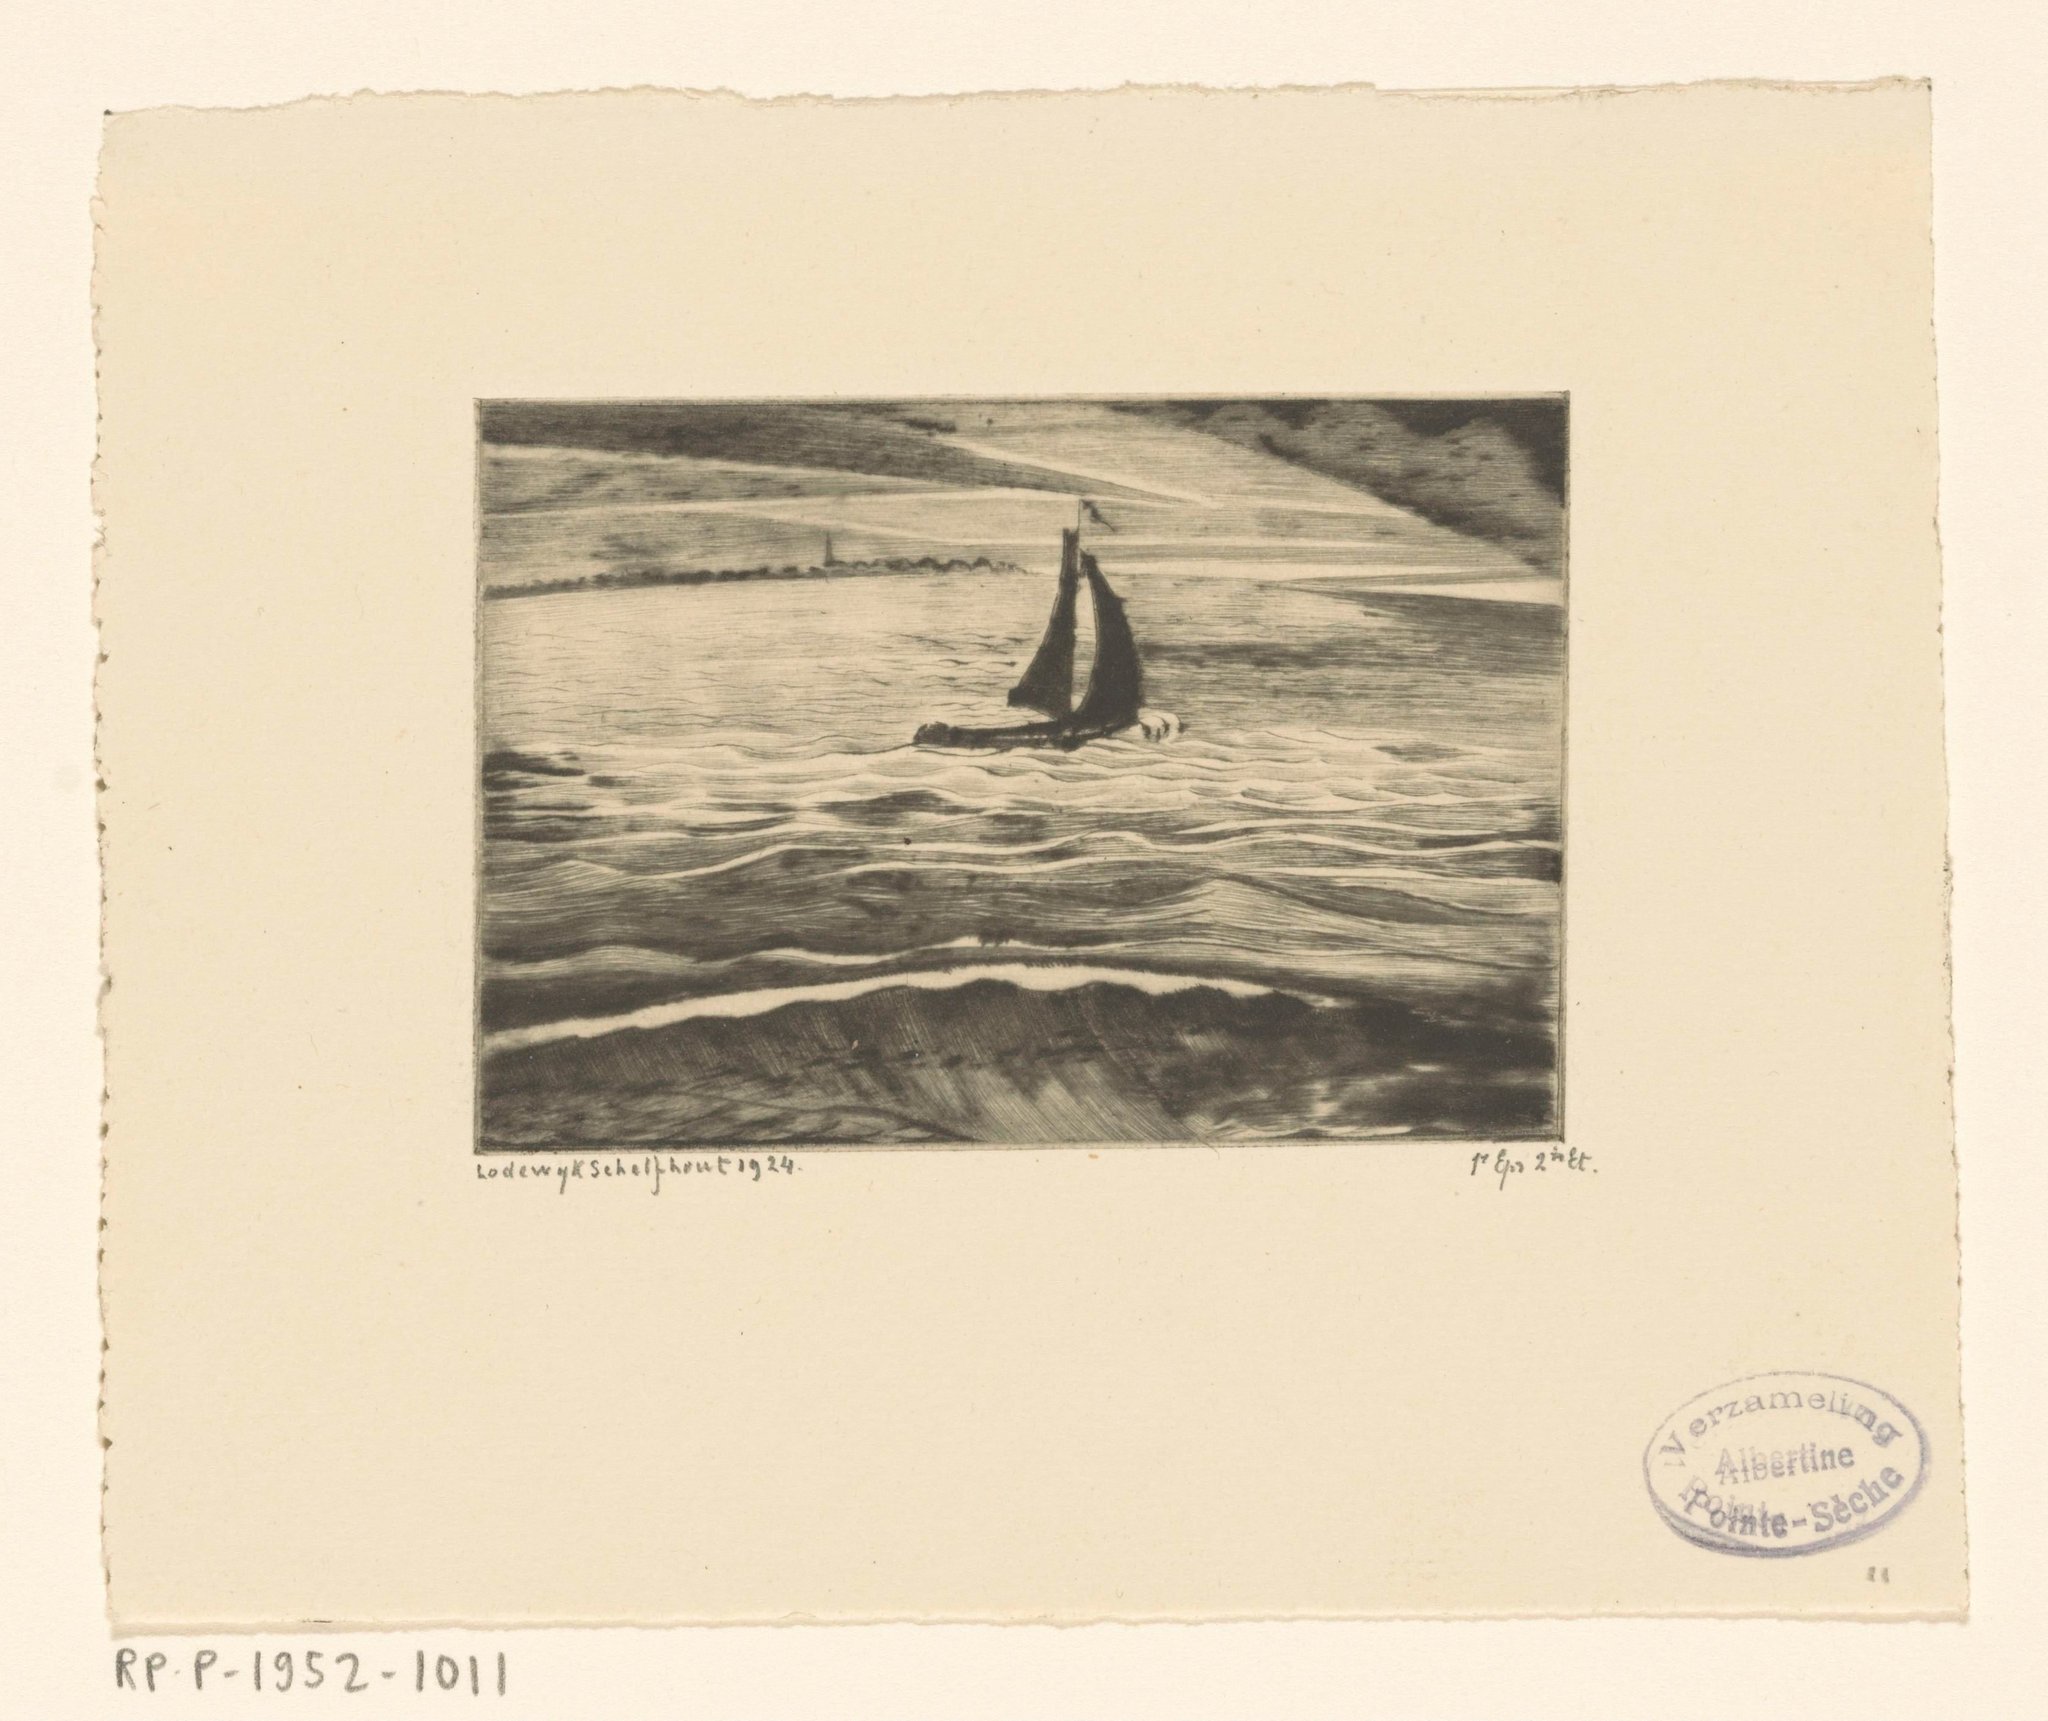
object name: print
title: Vue sur l'Île de Marken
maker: lodewijk schelfhout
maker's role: draughtsman, print maker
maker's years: 1881-1943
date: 1924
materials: paper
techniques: drypoint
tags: sailing-ship, sailing-boat, sea, zuiderzee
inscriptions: collector's mark: Lugt 5i, collector's mark: Lugt 2760, collector's mark: Lugt 2228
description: Een zeilschip op de Zuiderzee bij het eiland Marken.